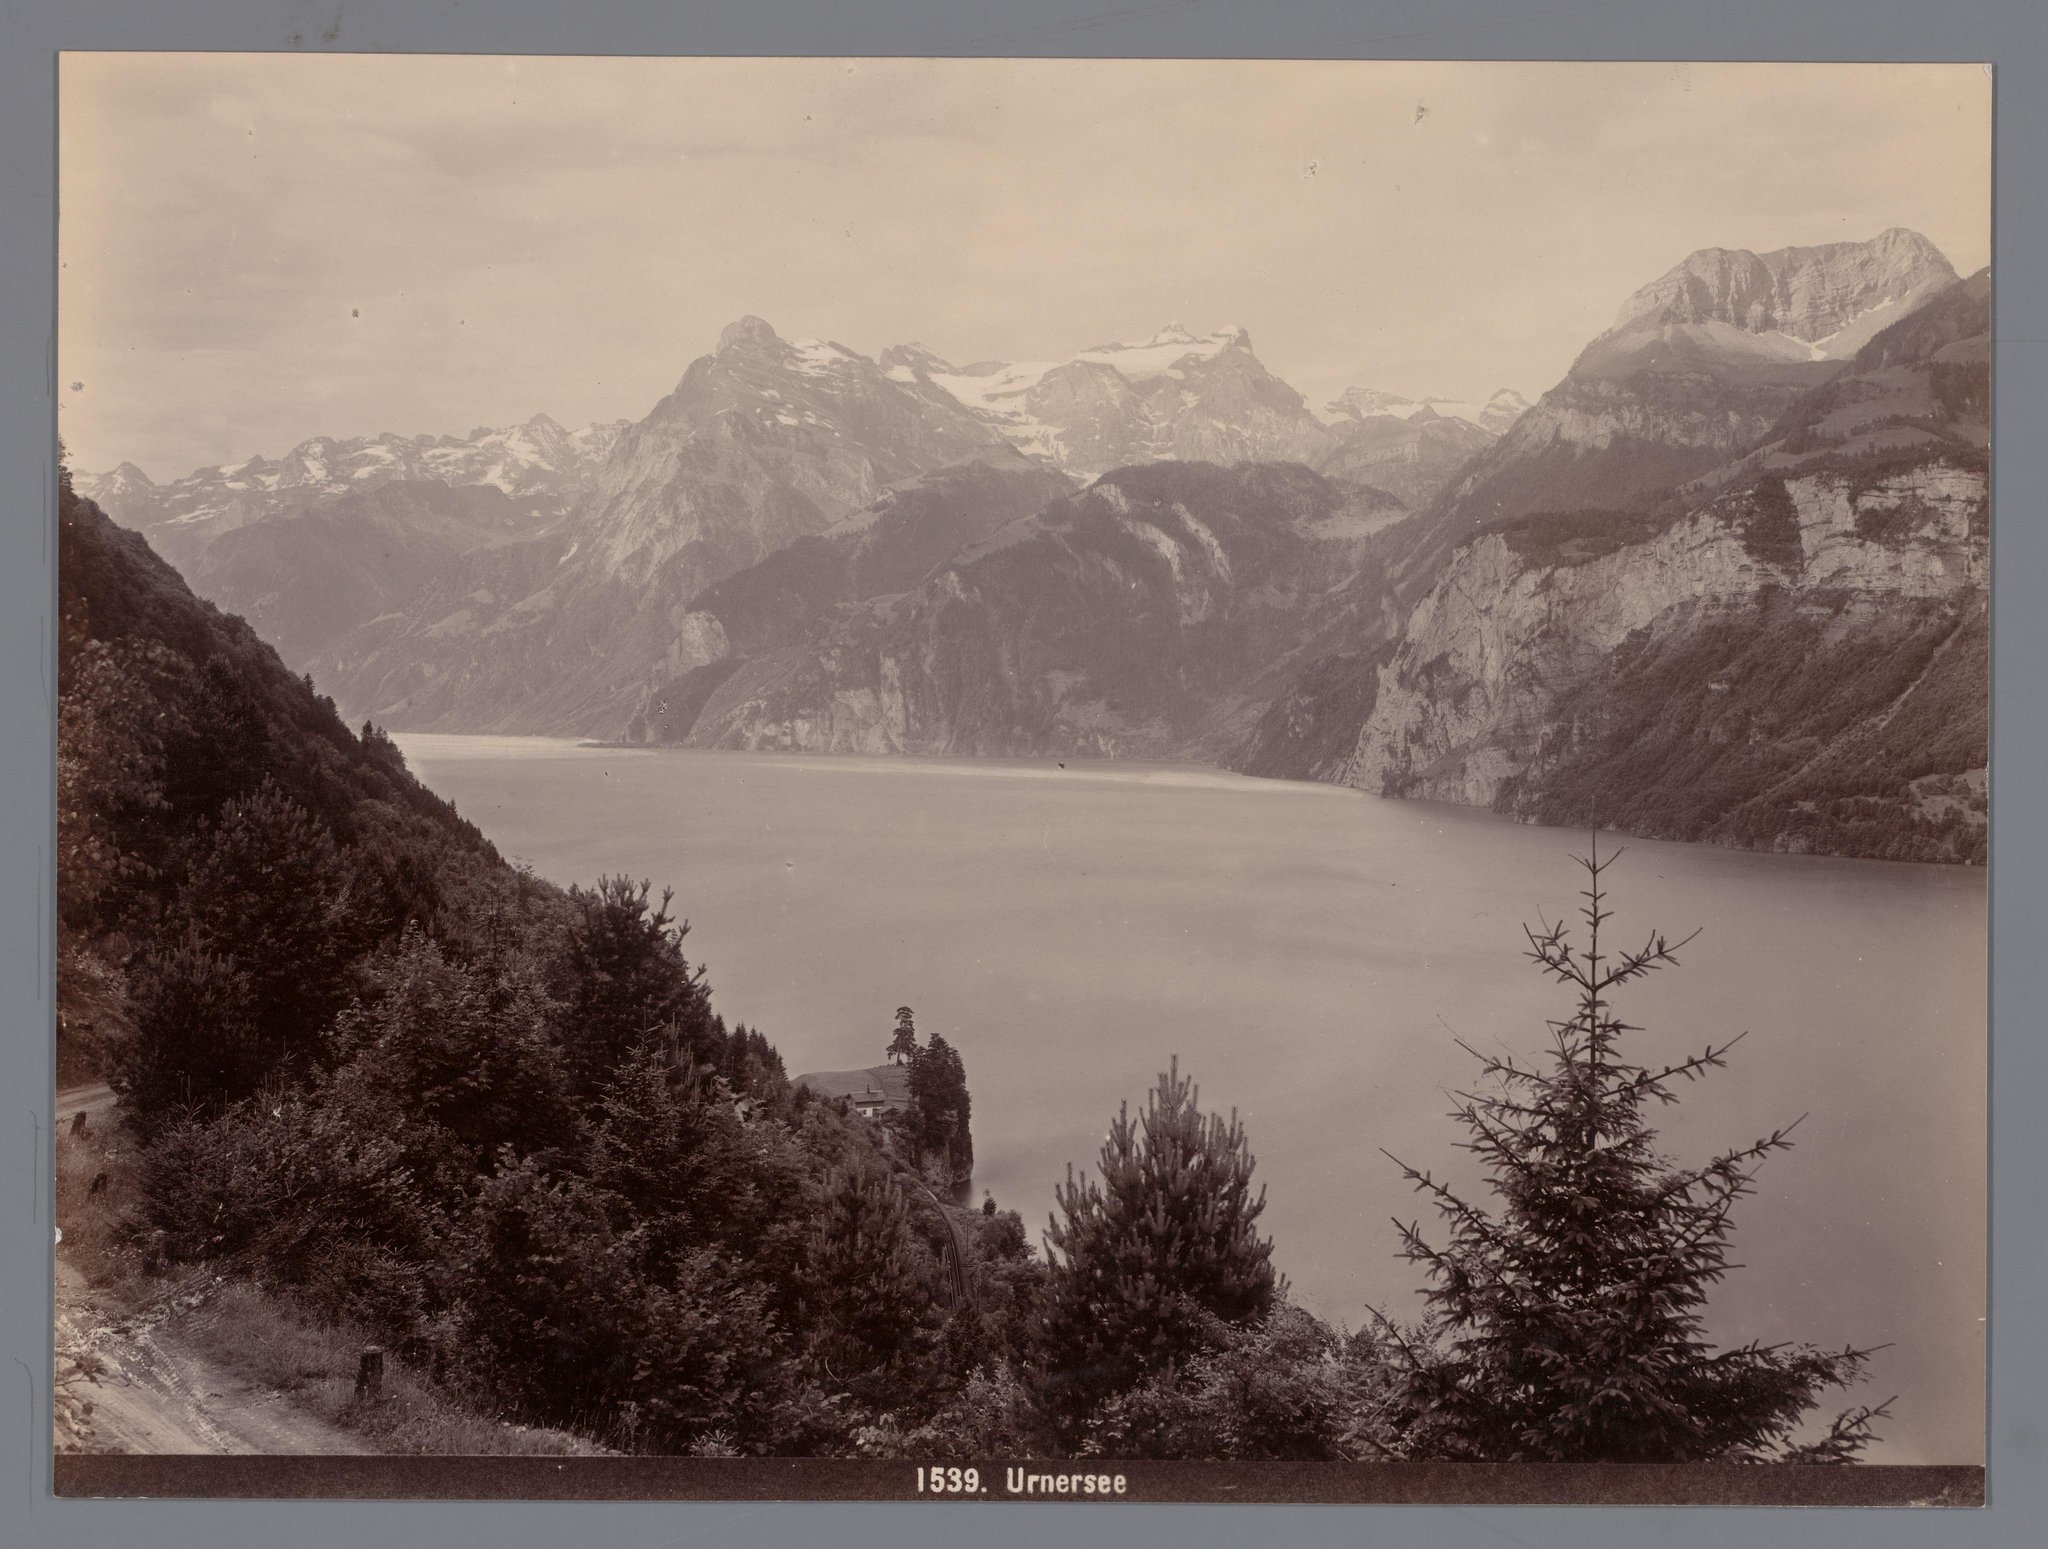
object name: photograph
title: Urnersee, kanton Uri, Zwitserland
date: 1900-1920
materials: paper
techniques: gelatin silver print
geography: switzerland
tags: switzerland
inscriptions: inscription: ‘F.’, inscription: ‘1539. Urnersee’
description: De Urnersee ligt in Centraal-Zwitserland en is geen zelfstandig meer, maar onderdeel van het Vierwoudstrekenmeer [Duits: Vierwaldstättersee]. Een bergmassief is te zien op de achtergrond.